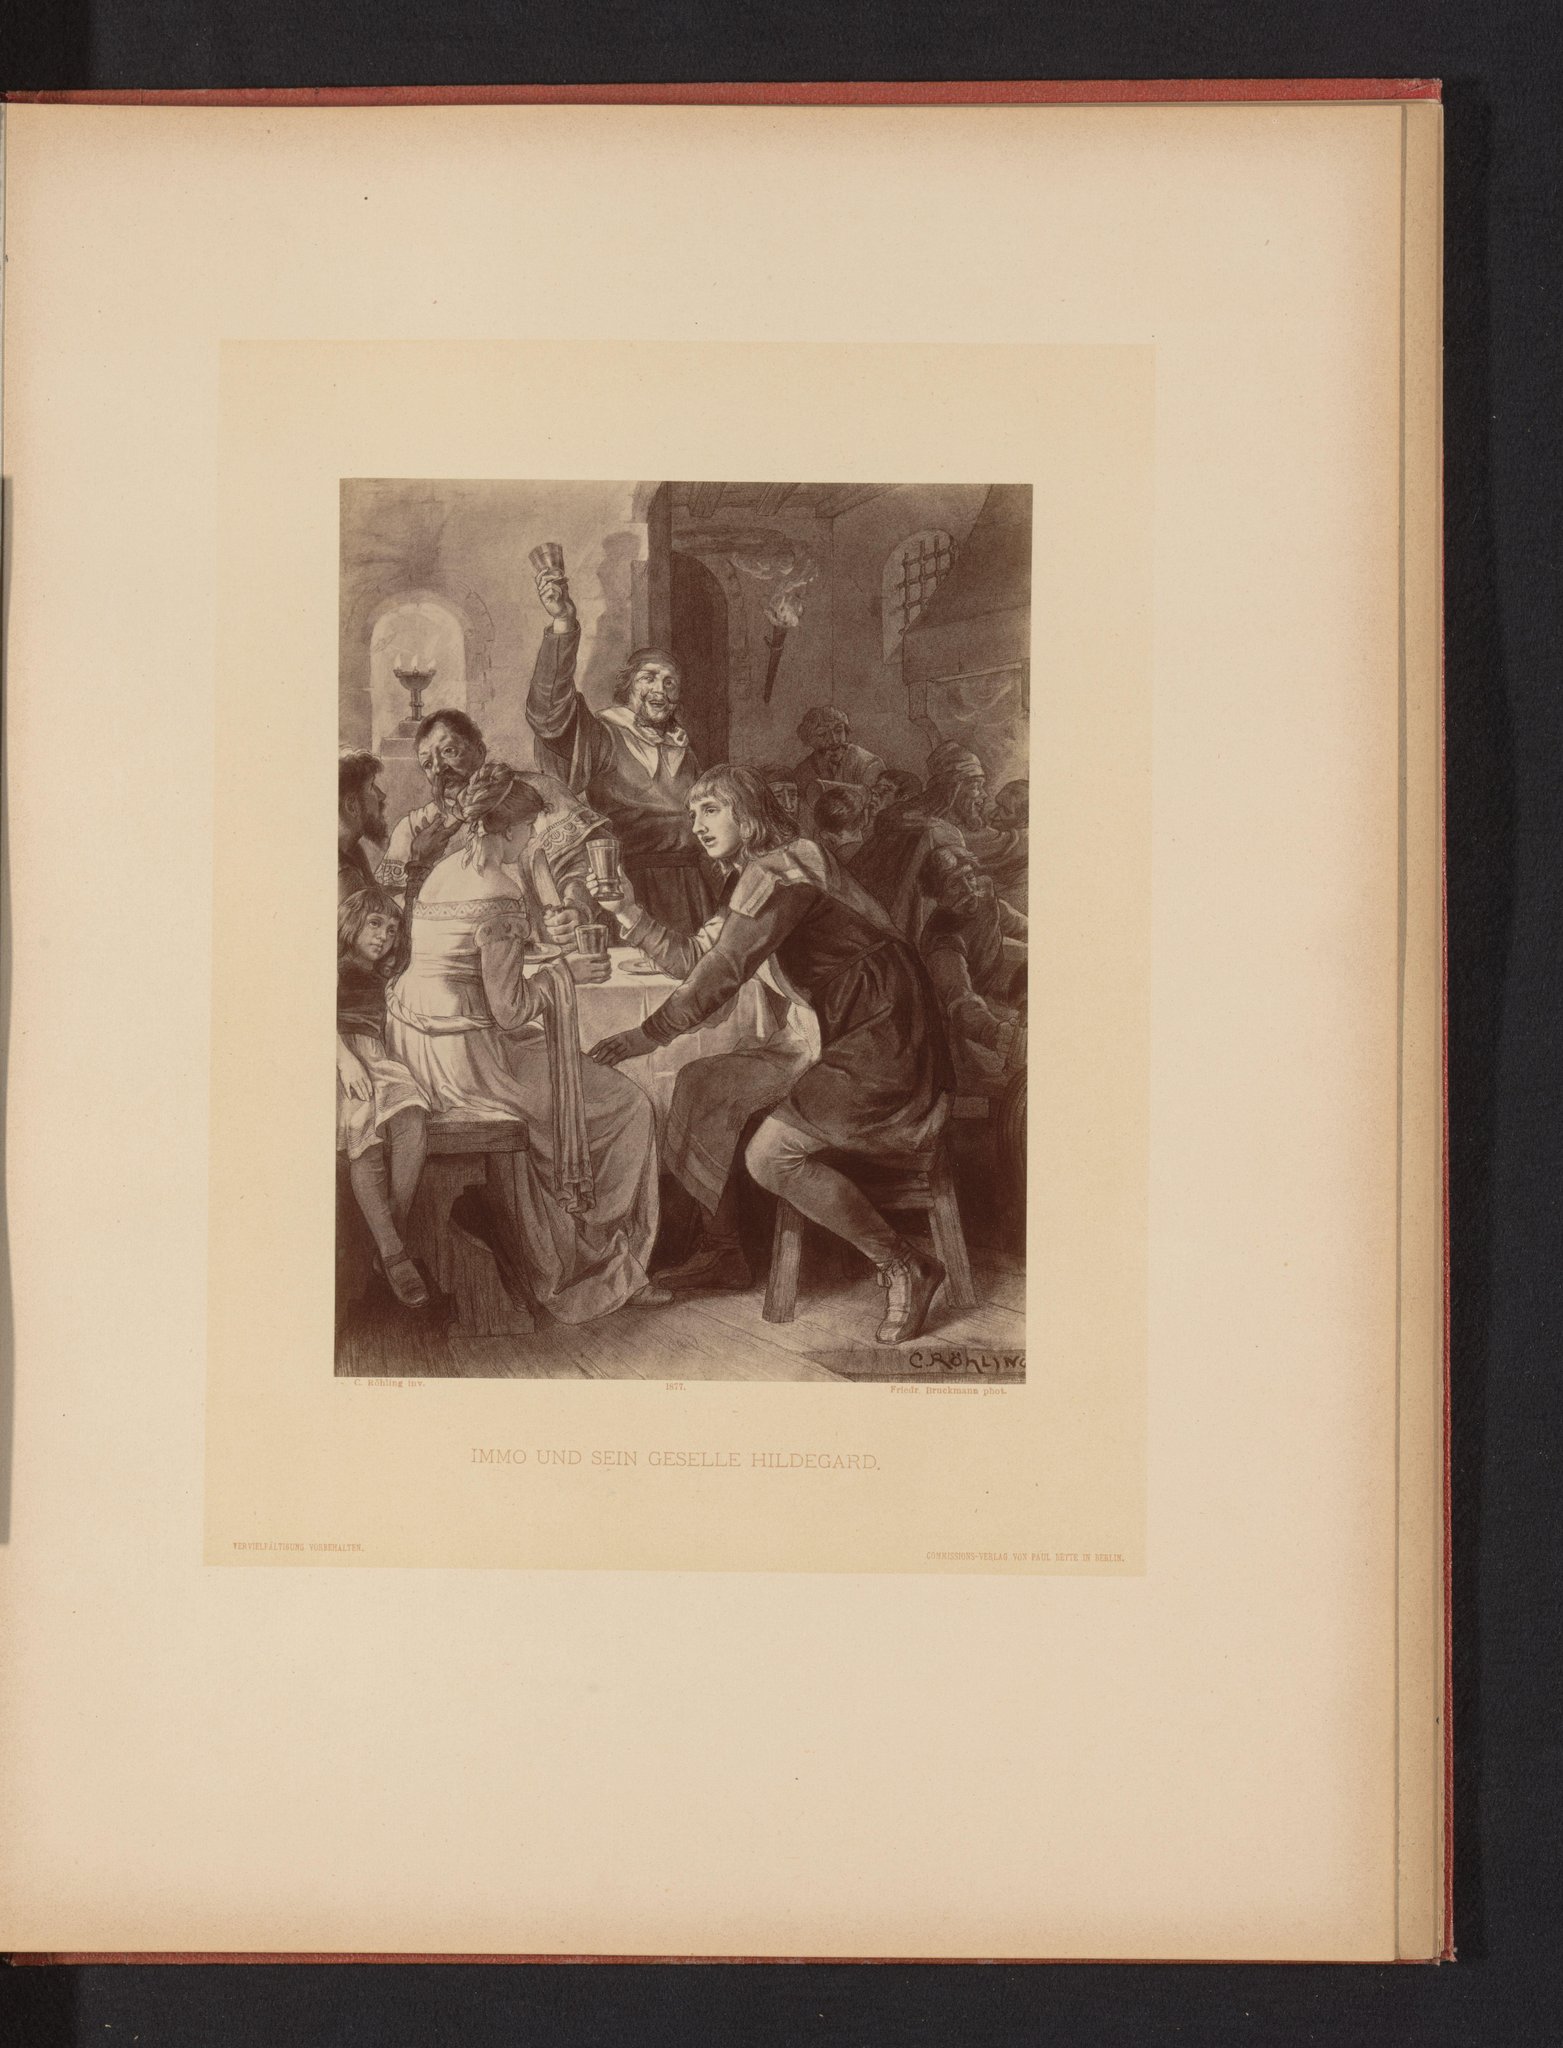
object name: page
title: Reproductie van een tekening van een scene met Immo en Hildegard uit Die Ahnen van Gustav Freitag, door Carl Röhling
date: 1877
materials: paper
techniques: woodburytype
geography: berlin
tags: inn, coffee-house, public house, etc., specific works of literature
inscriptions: inscription: ‘VERVIELFÄLTIGUNG VORBEHALTEN.’